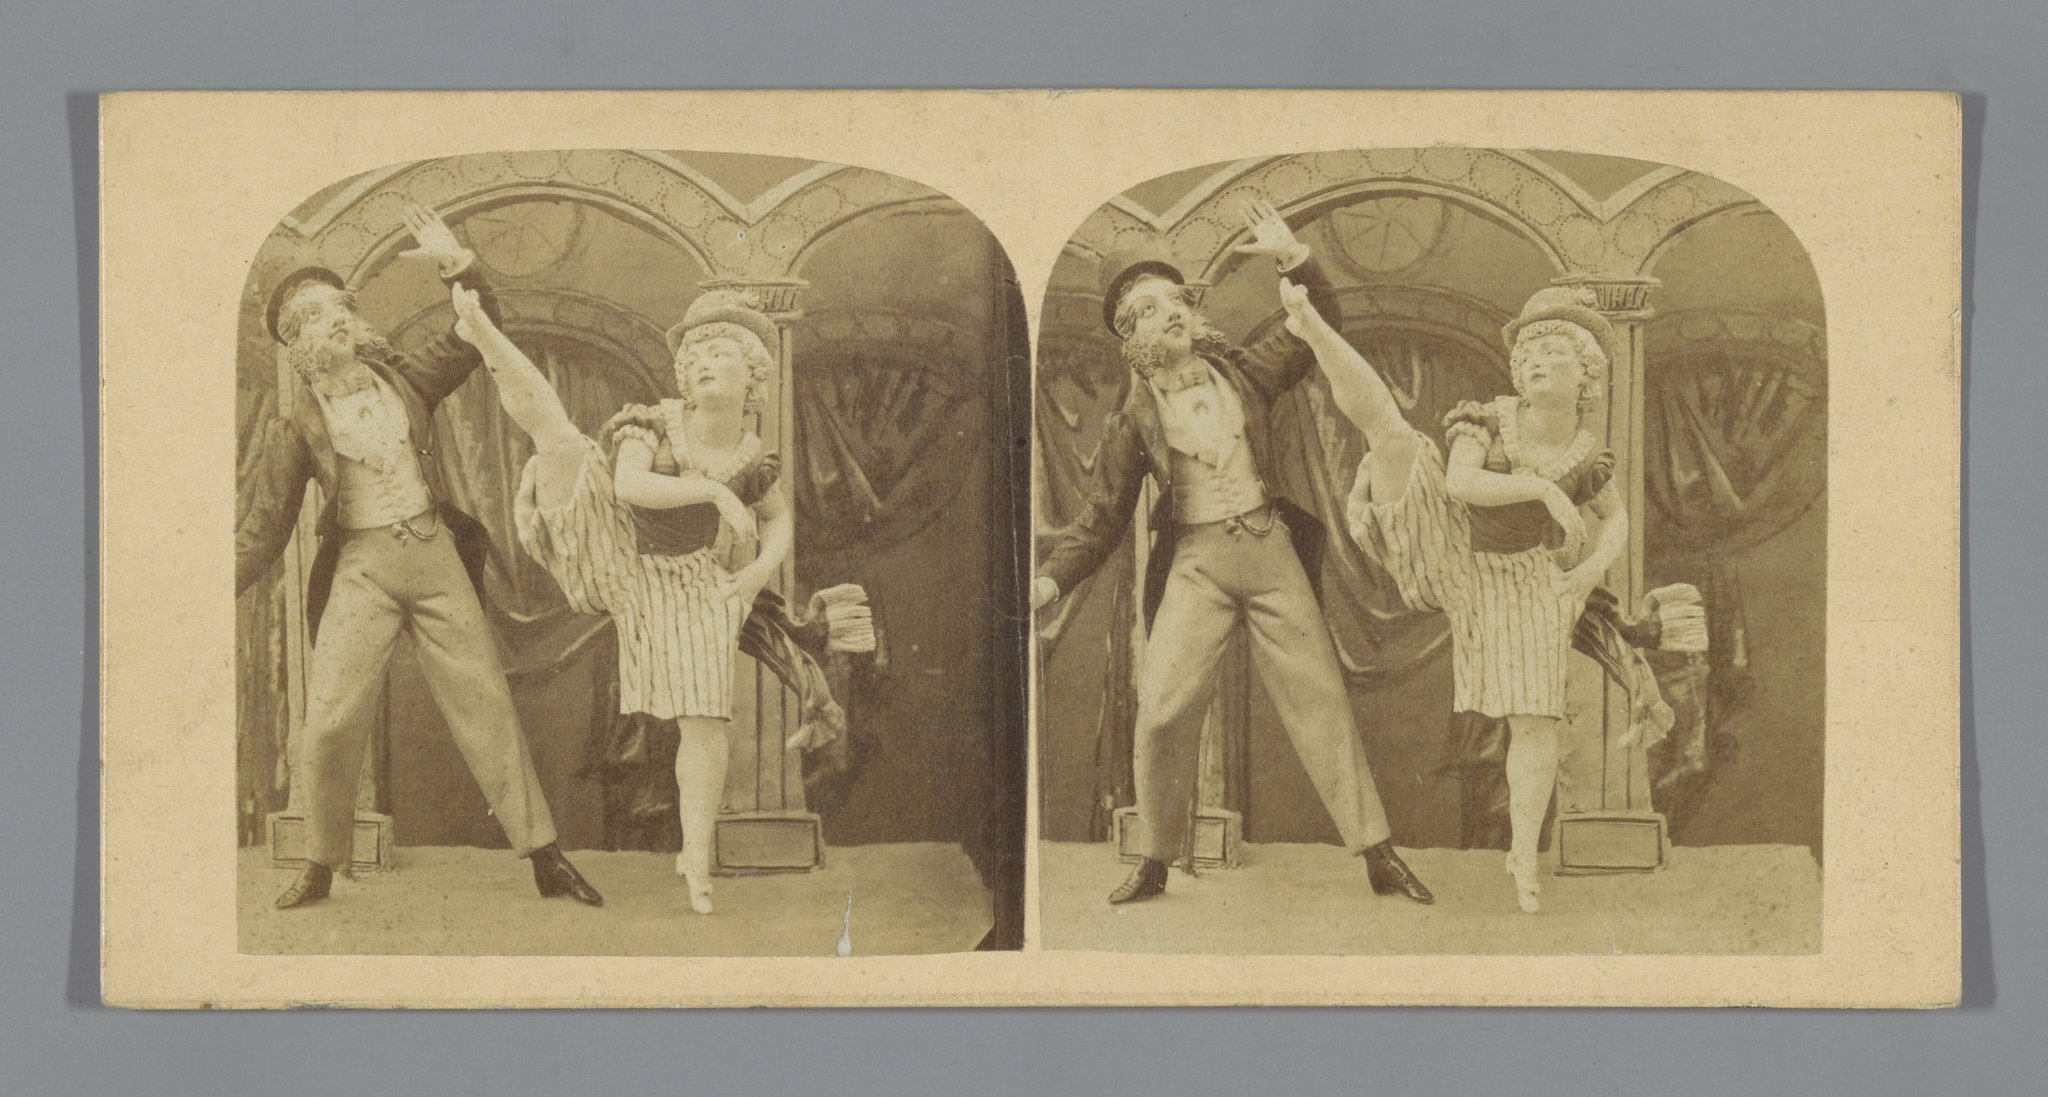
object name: stereograph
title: Sculpturen van dansende man en vrouw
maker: Anonymous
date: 1855-1880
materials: cardboard, photographic support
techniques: albumen print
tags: one pair dancing; man and woman dancing as a couple, sculpture